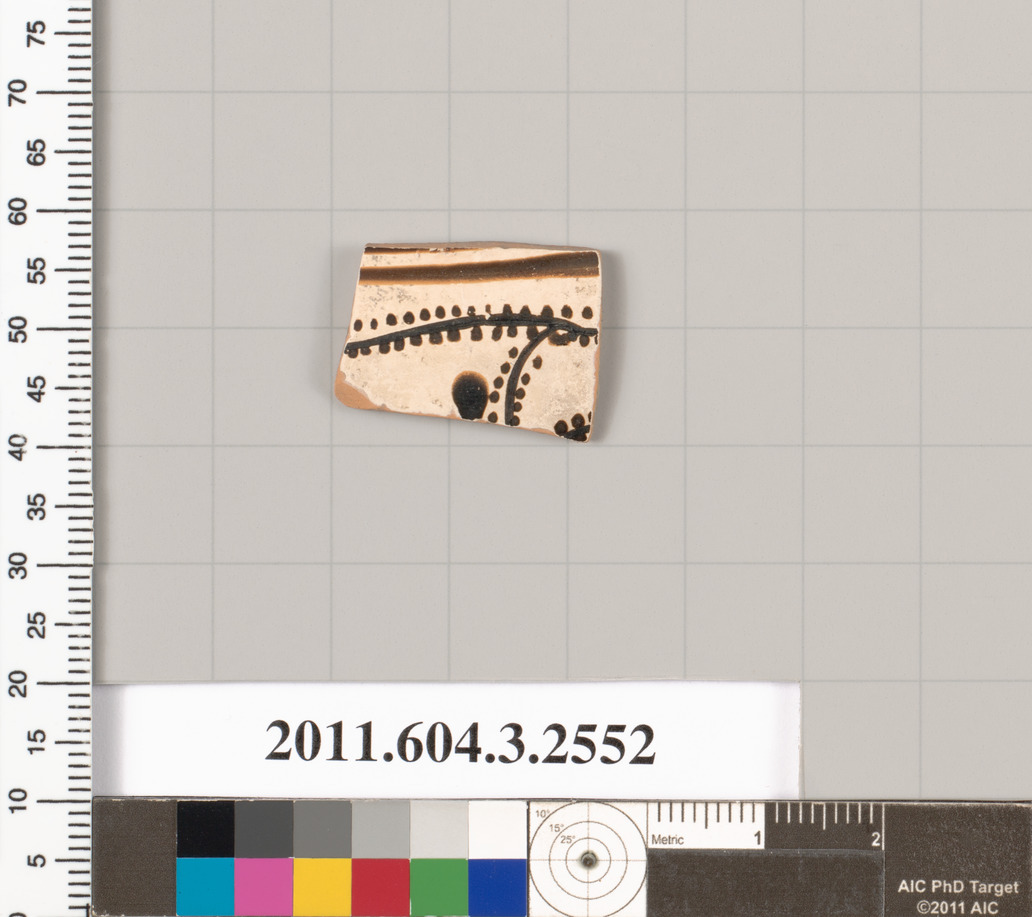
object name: kylix fragment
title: Terracotta fragment of a kylix (drinking cup)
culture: greek, attic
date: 534-468 BCE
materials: terracotta